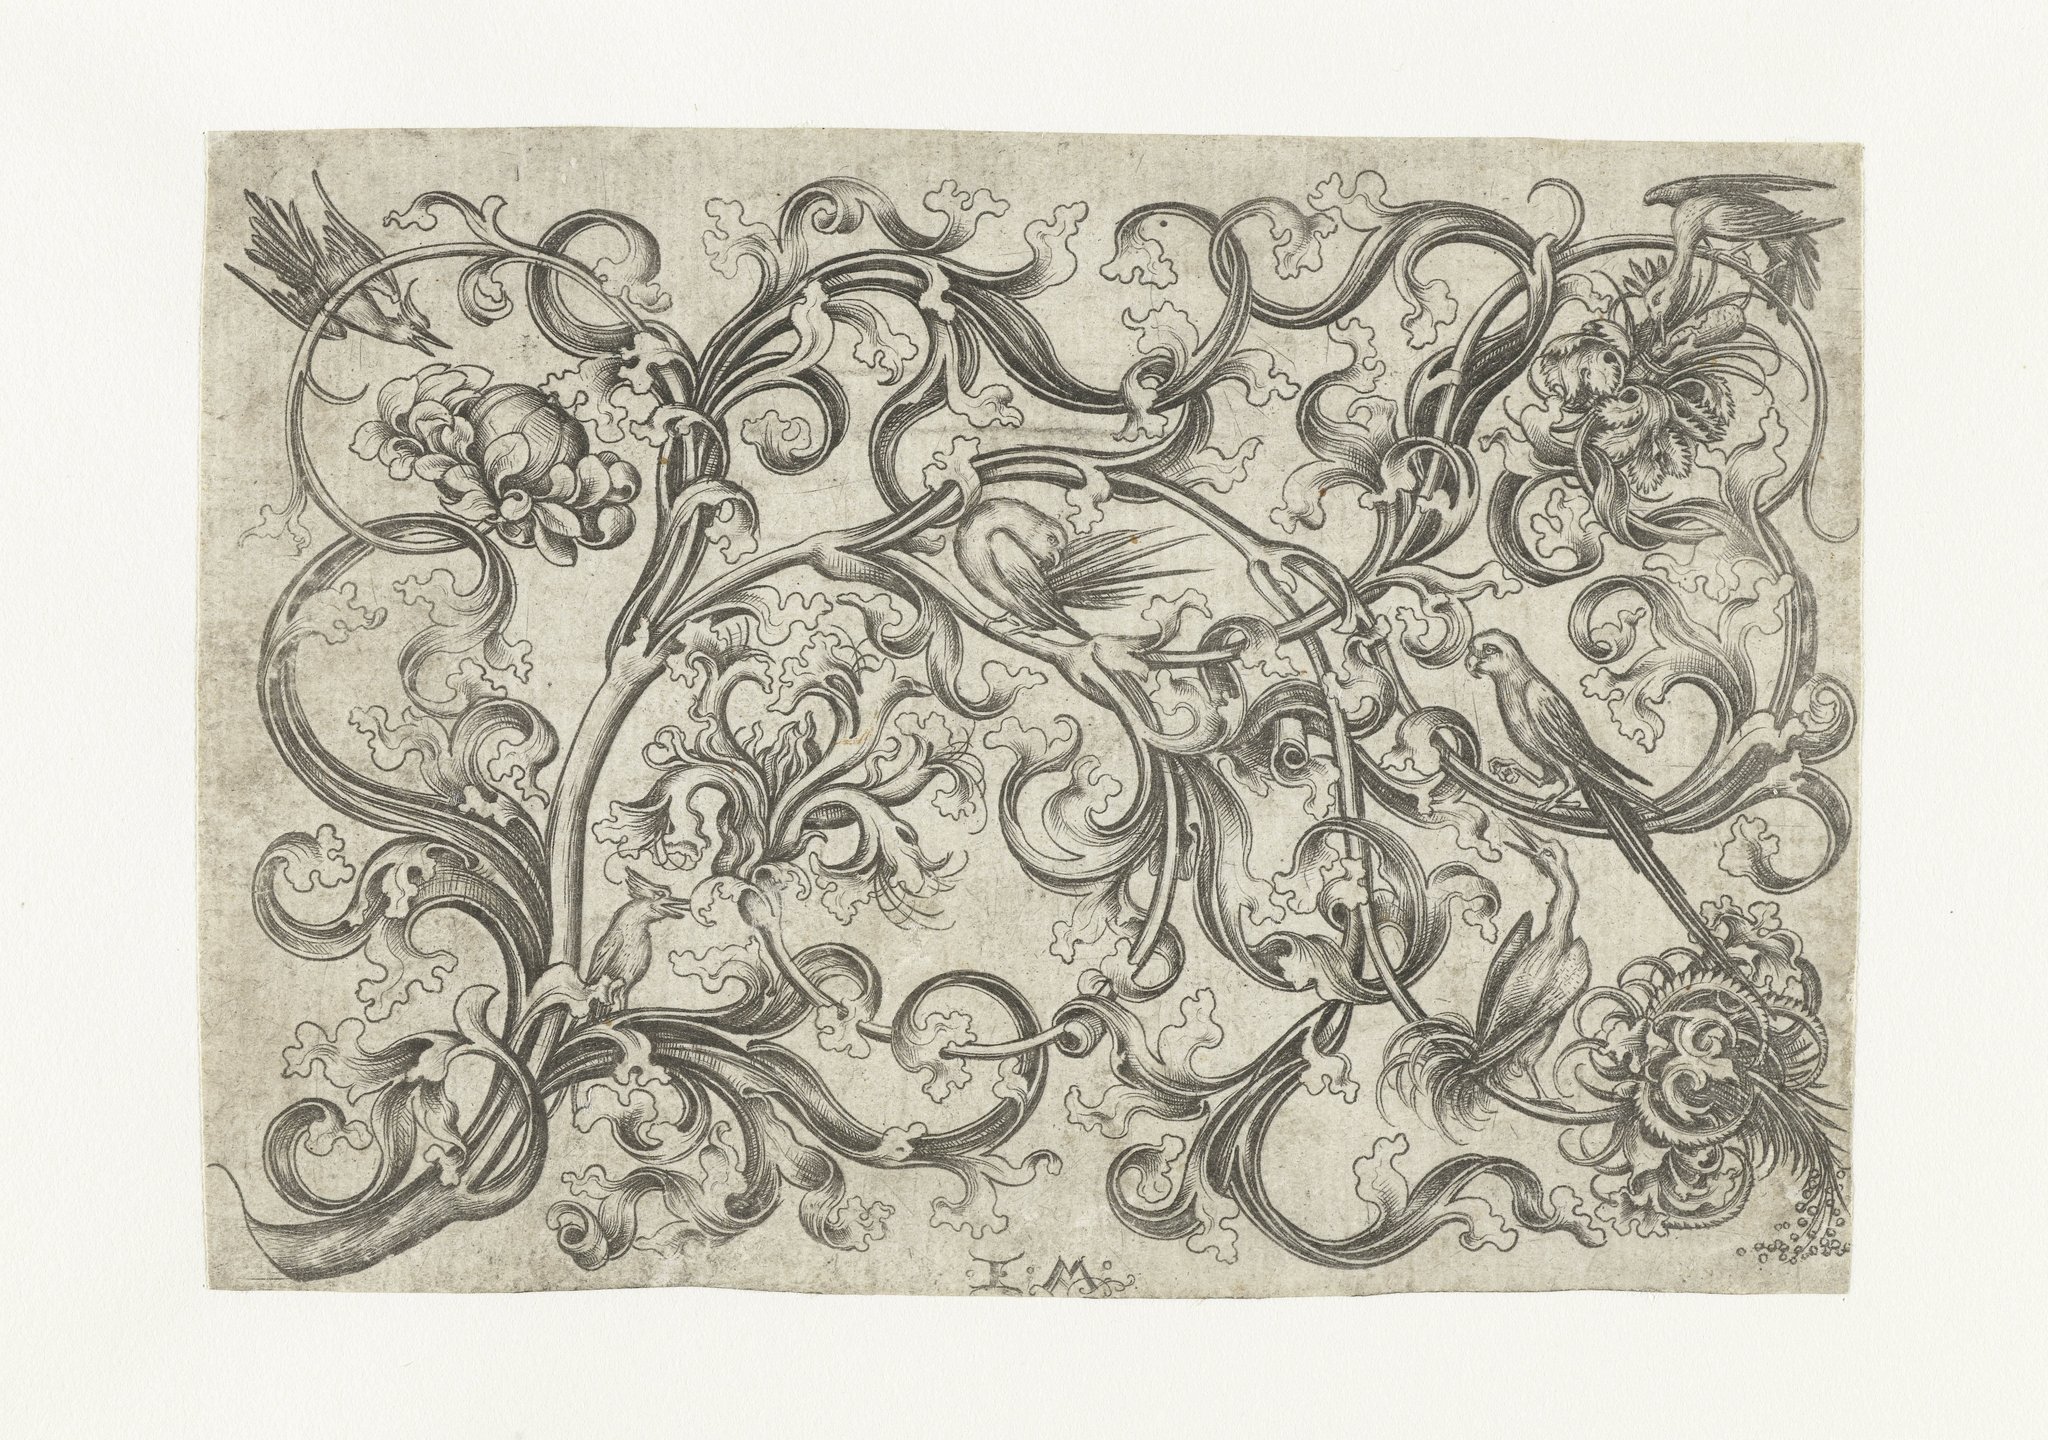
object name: print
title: Ranken met papegaaien en andere vogels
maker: israhel van meckenem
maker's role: print maker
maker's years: 1440-1517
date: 1455-1503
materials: paper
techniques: engraving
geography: bocholt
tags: ornamental birds, plants; vegetation (+ ornamental variants of plants), ornamental birds: parrot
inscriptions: collector's mark: Lugt 240